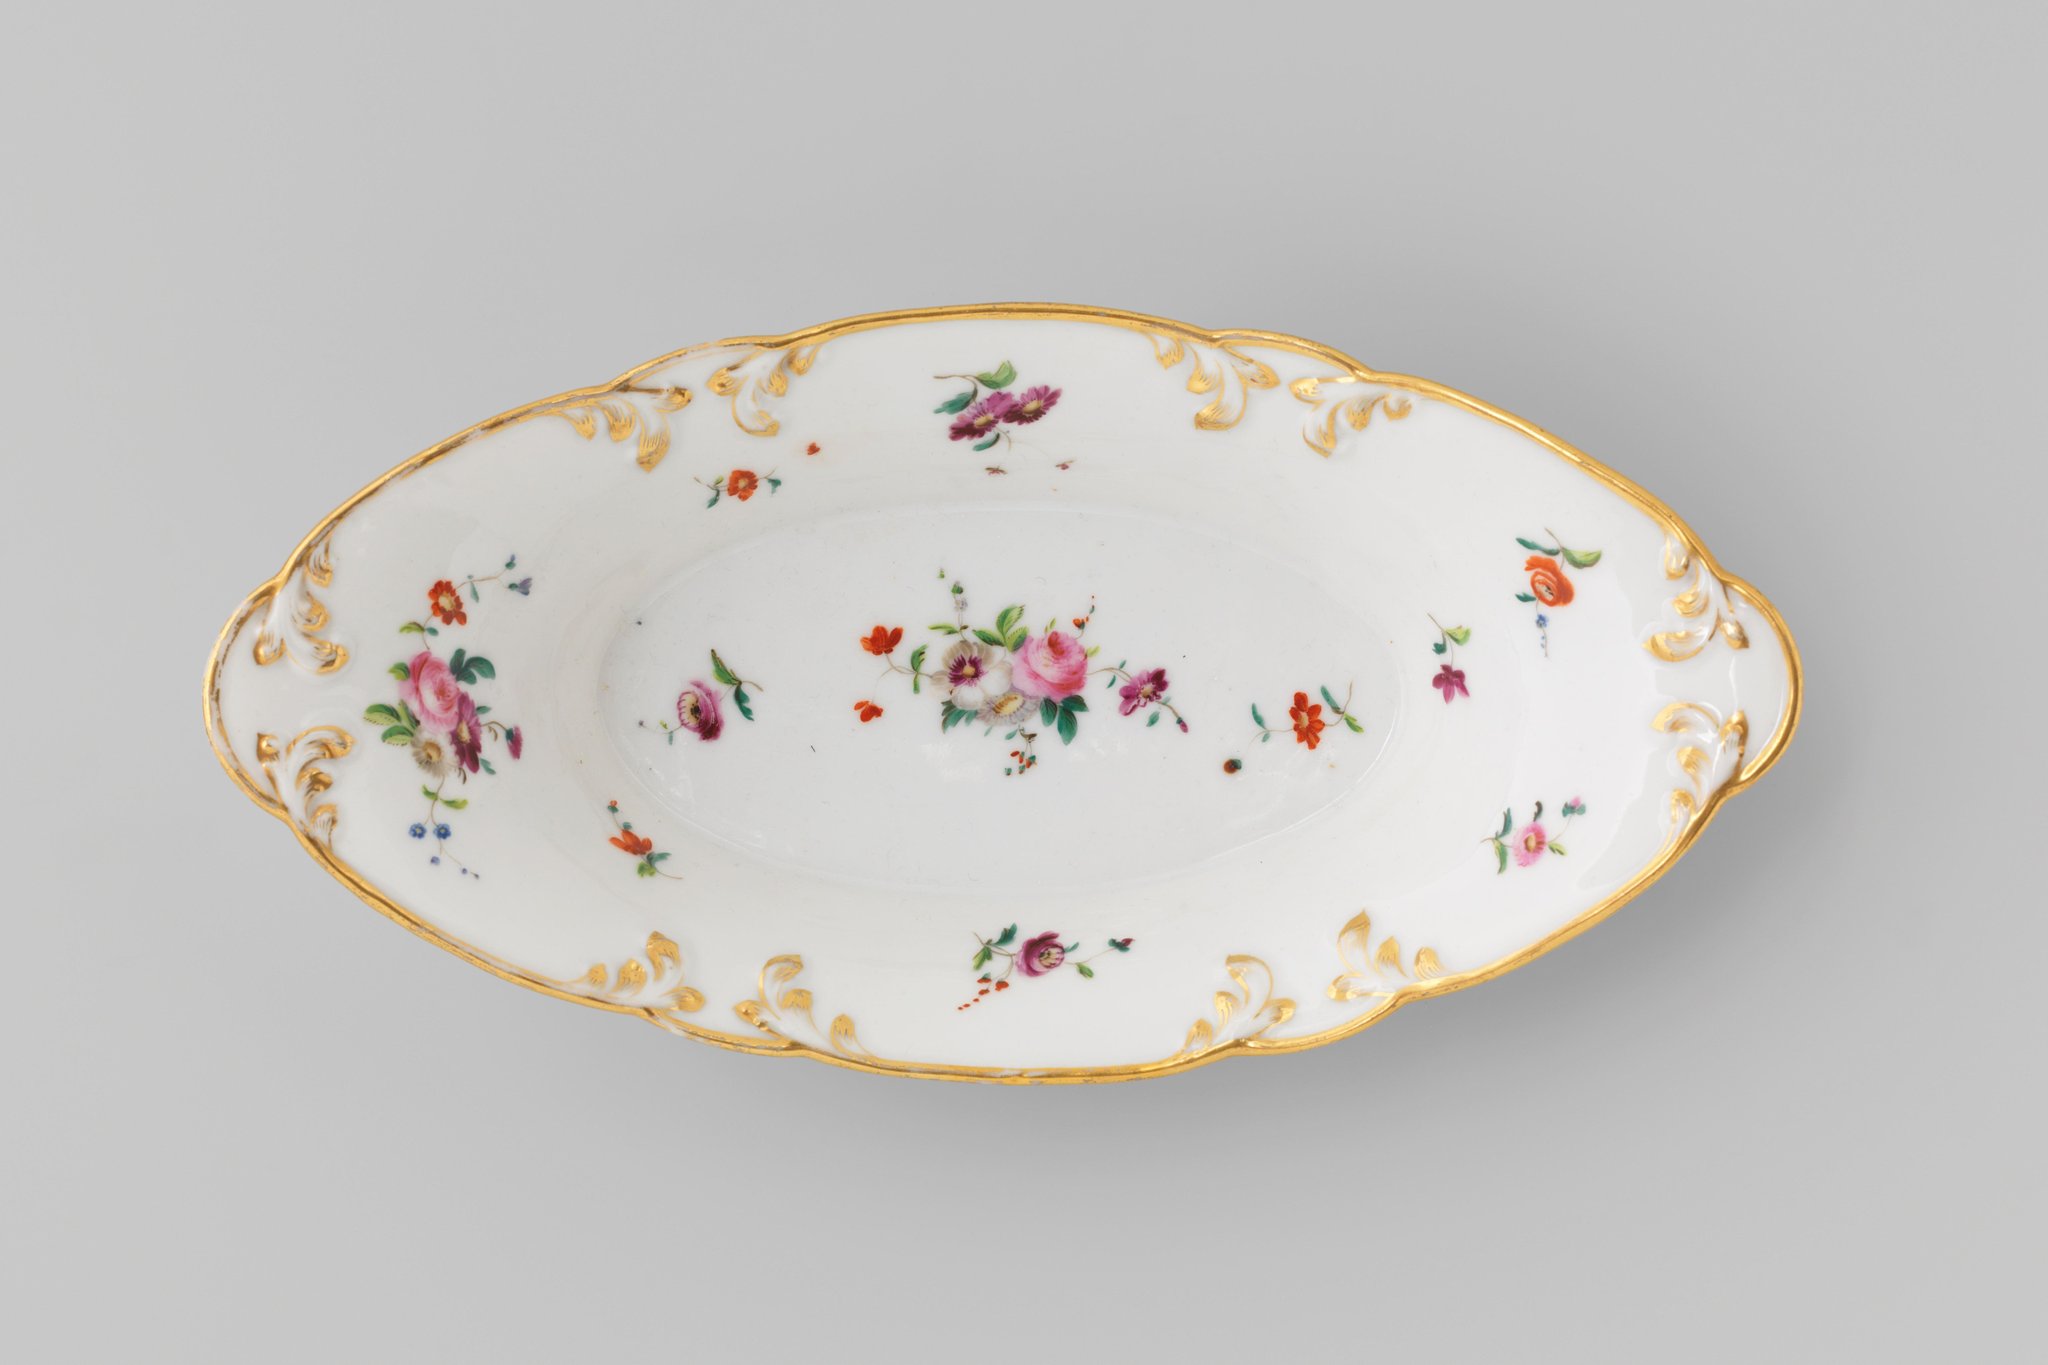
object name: service set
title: Dish with bouquets and flower sprays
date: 1839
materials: glaze, gold, paint, porcelain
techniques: firing, forming, gilding, turning, vitrification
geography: paris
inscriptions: mark: ‘DENUELLE/ Boulevard St. Denis 18/ à Paris’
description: Ovale schaal van porselein met een gelobde rand en de uiteinden spits toelopend, beschilderd op het glazuur in blauw, rood, roze, groen, geel, paars, zwart en goud. Op het plat, de binnen- en buitenwand boeketten van verschillende bloemen en strooibloemen. Vanuit de gelobde, gouden rand, op de binnenwand gemodelleerde bladranken in reliëf, aangezet met goud. Gouden lijn boven de voet. Gemerkt op de onderzijde met 'DENUELLE/ Boulevard St. Denis 18/ à Paris'.